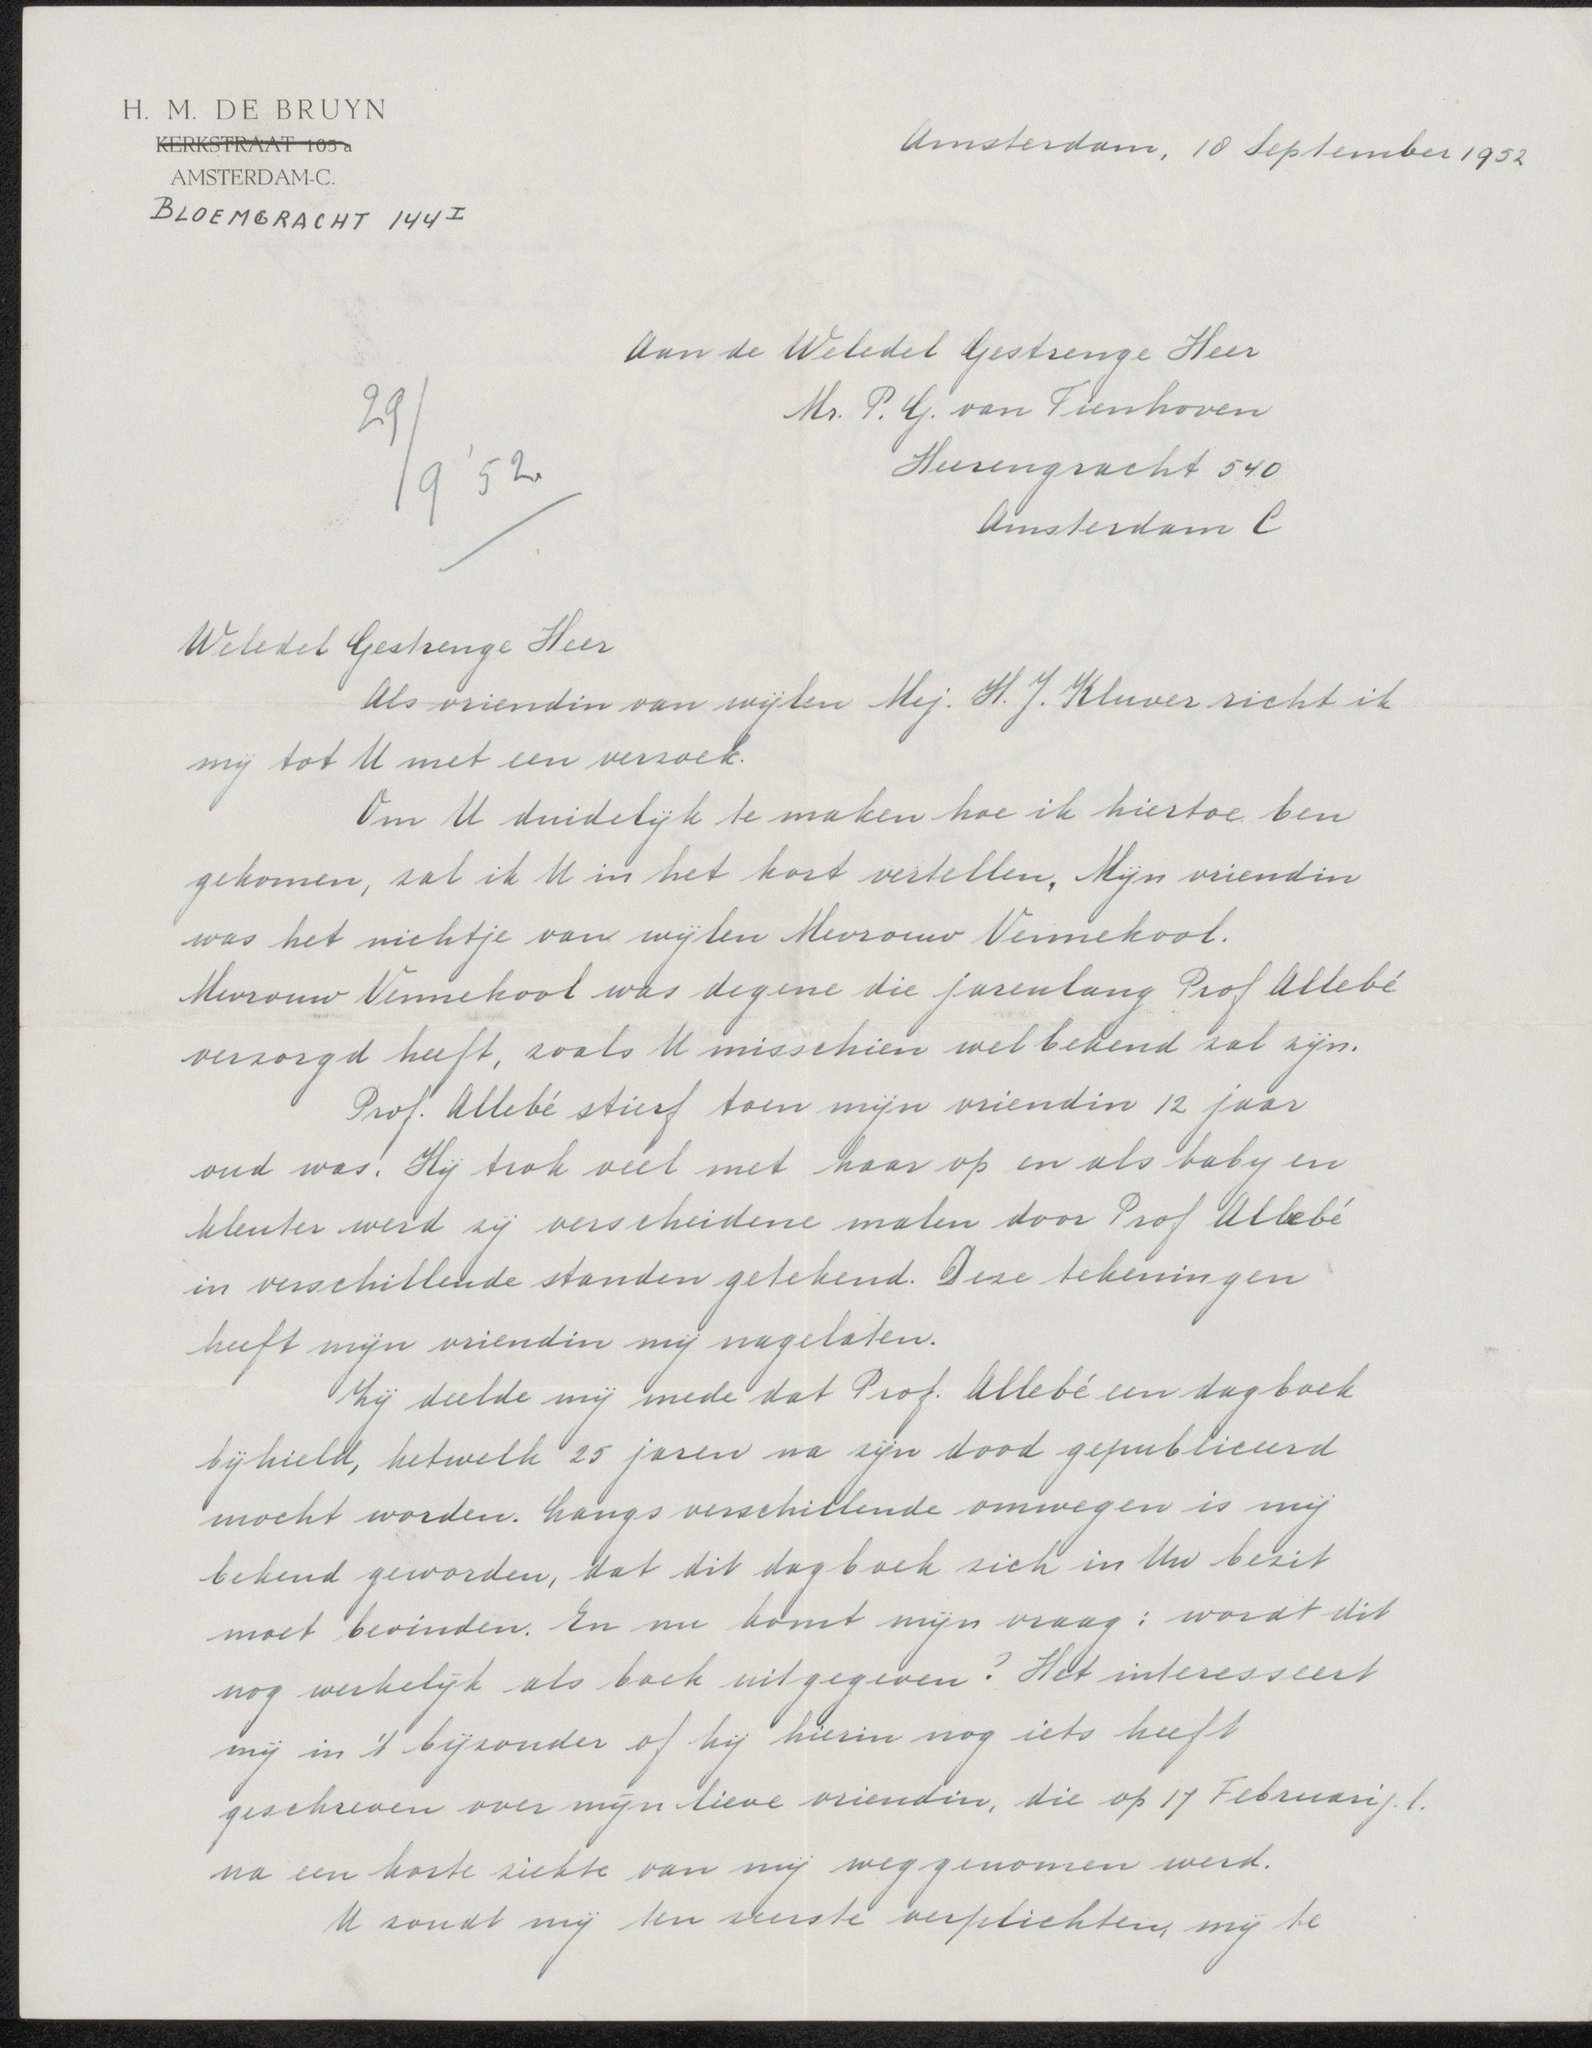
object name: letter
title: Brief aan Pieter Gerbrand van Tienhoven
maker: h.m. de bruyn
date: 1952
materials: ink, paper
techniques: pen, printing, writing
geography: amsterdam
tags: anna eva vennekool-kluver, print maker, draughtsman, august allebé, pieter gerbrand van tienhoven, drawing, diseases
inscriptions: watermark